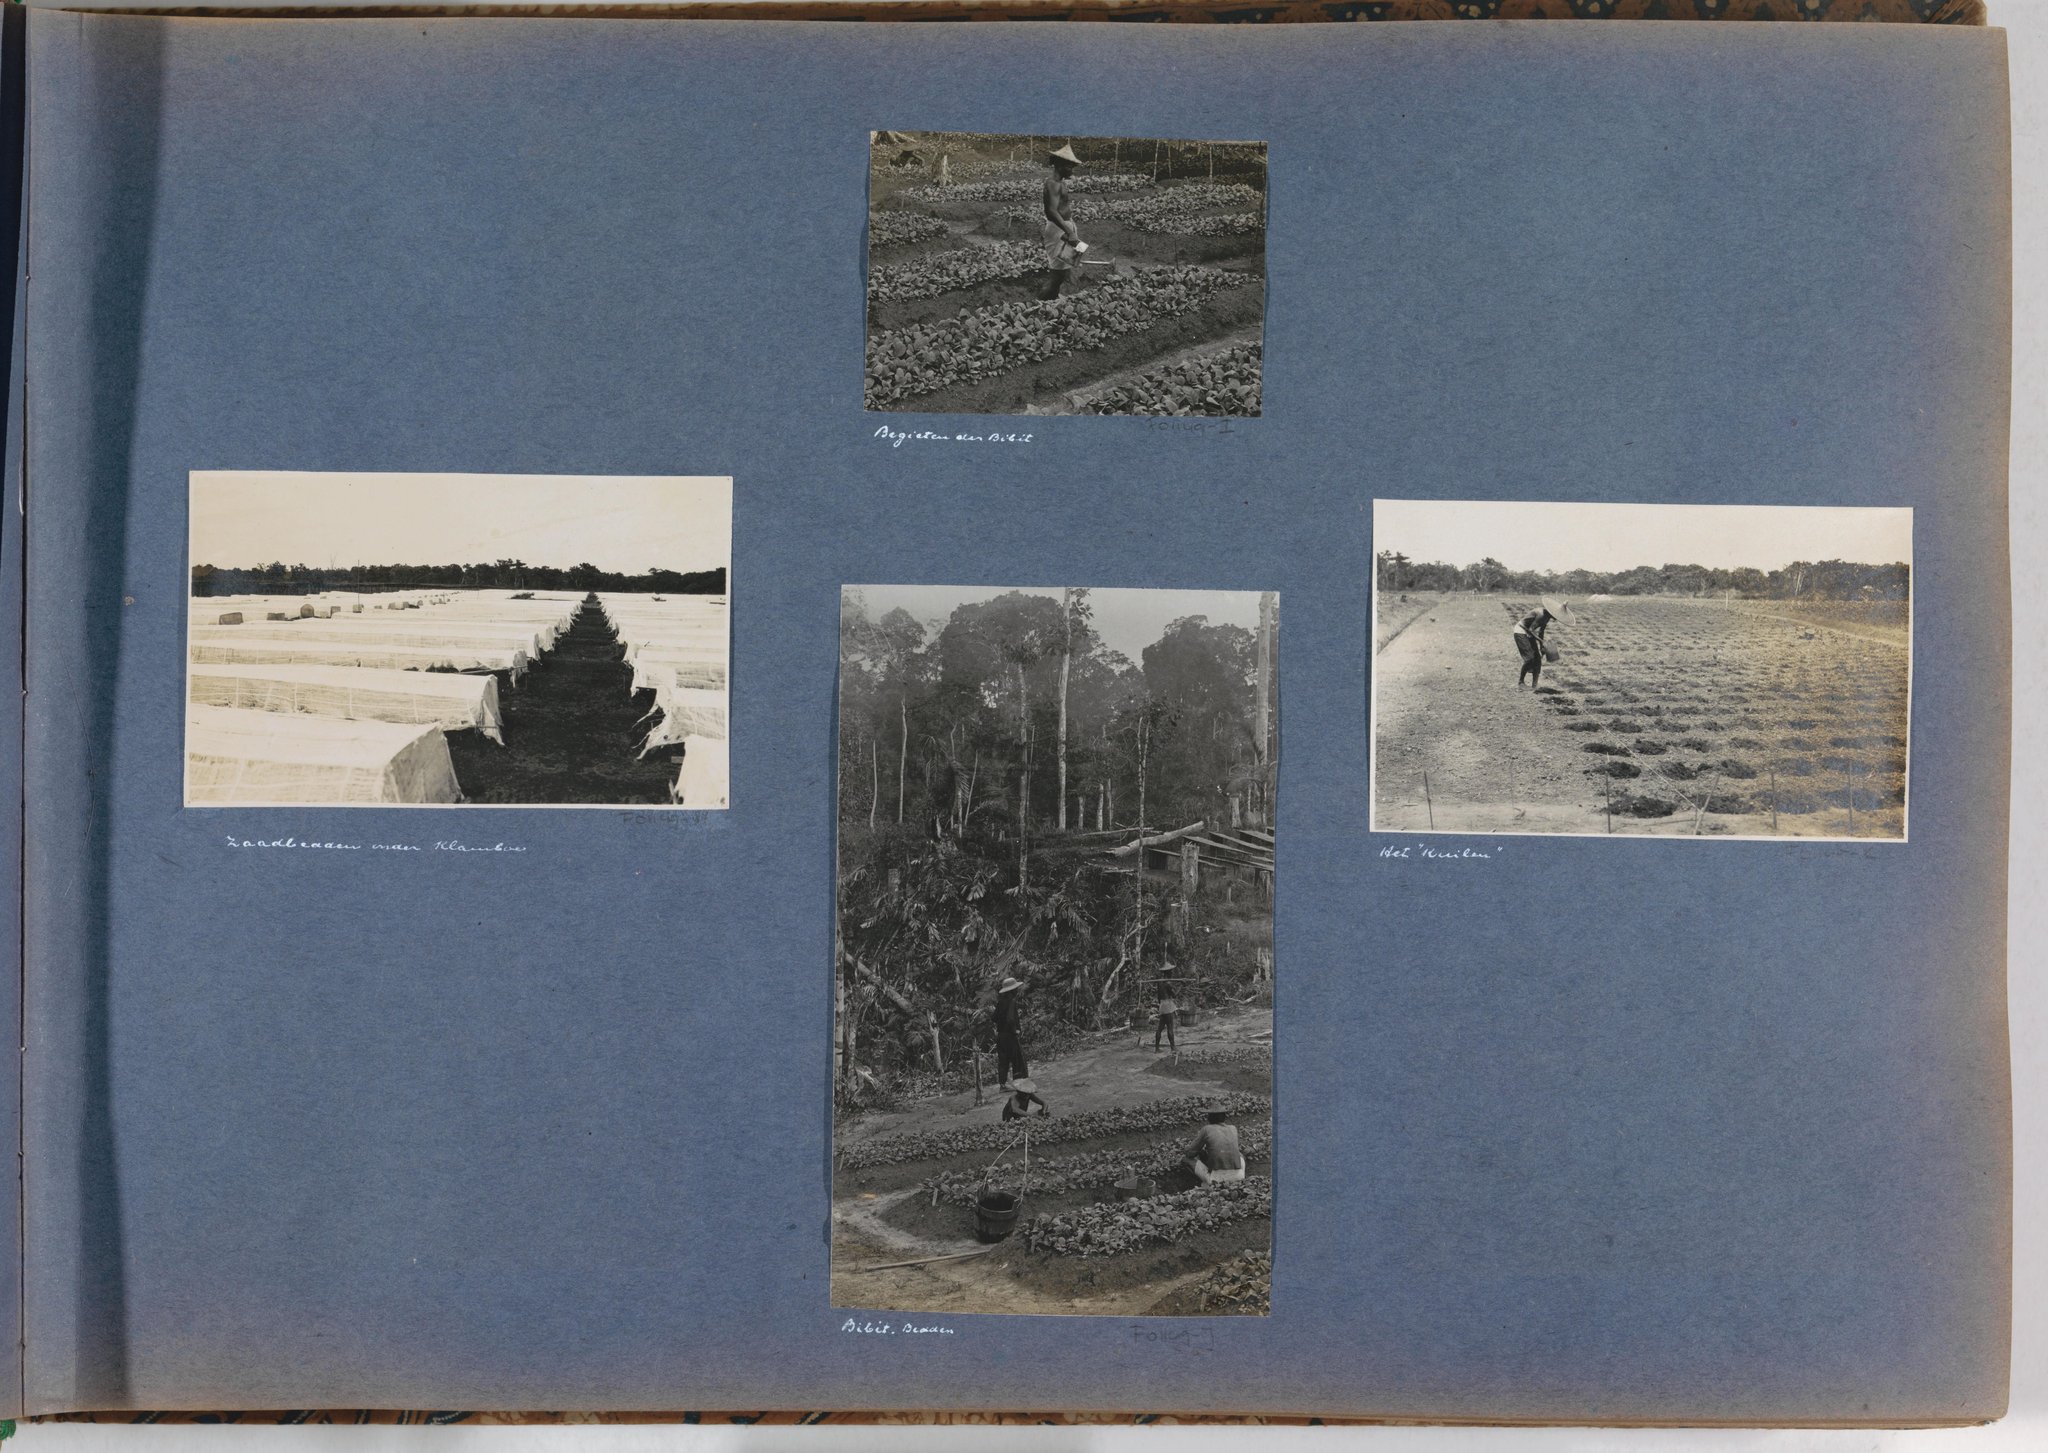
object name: album leaf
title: Begieten der Bibit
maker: Anonymous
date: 1900-1920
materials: paper, photographic support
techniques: gelatin silver print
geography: sumatra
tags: plantation, irrigation ~ cultivation, working class, labourers, tobacco, sumatra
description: Mogelijk gaat het om een contractarbeider. Onderdeel van reisalbum met foto's van bedrijvigheid en bezienswaardigheden op Sumatra en Java en van de reis naar en van Nederlands-Indië.